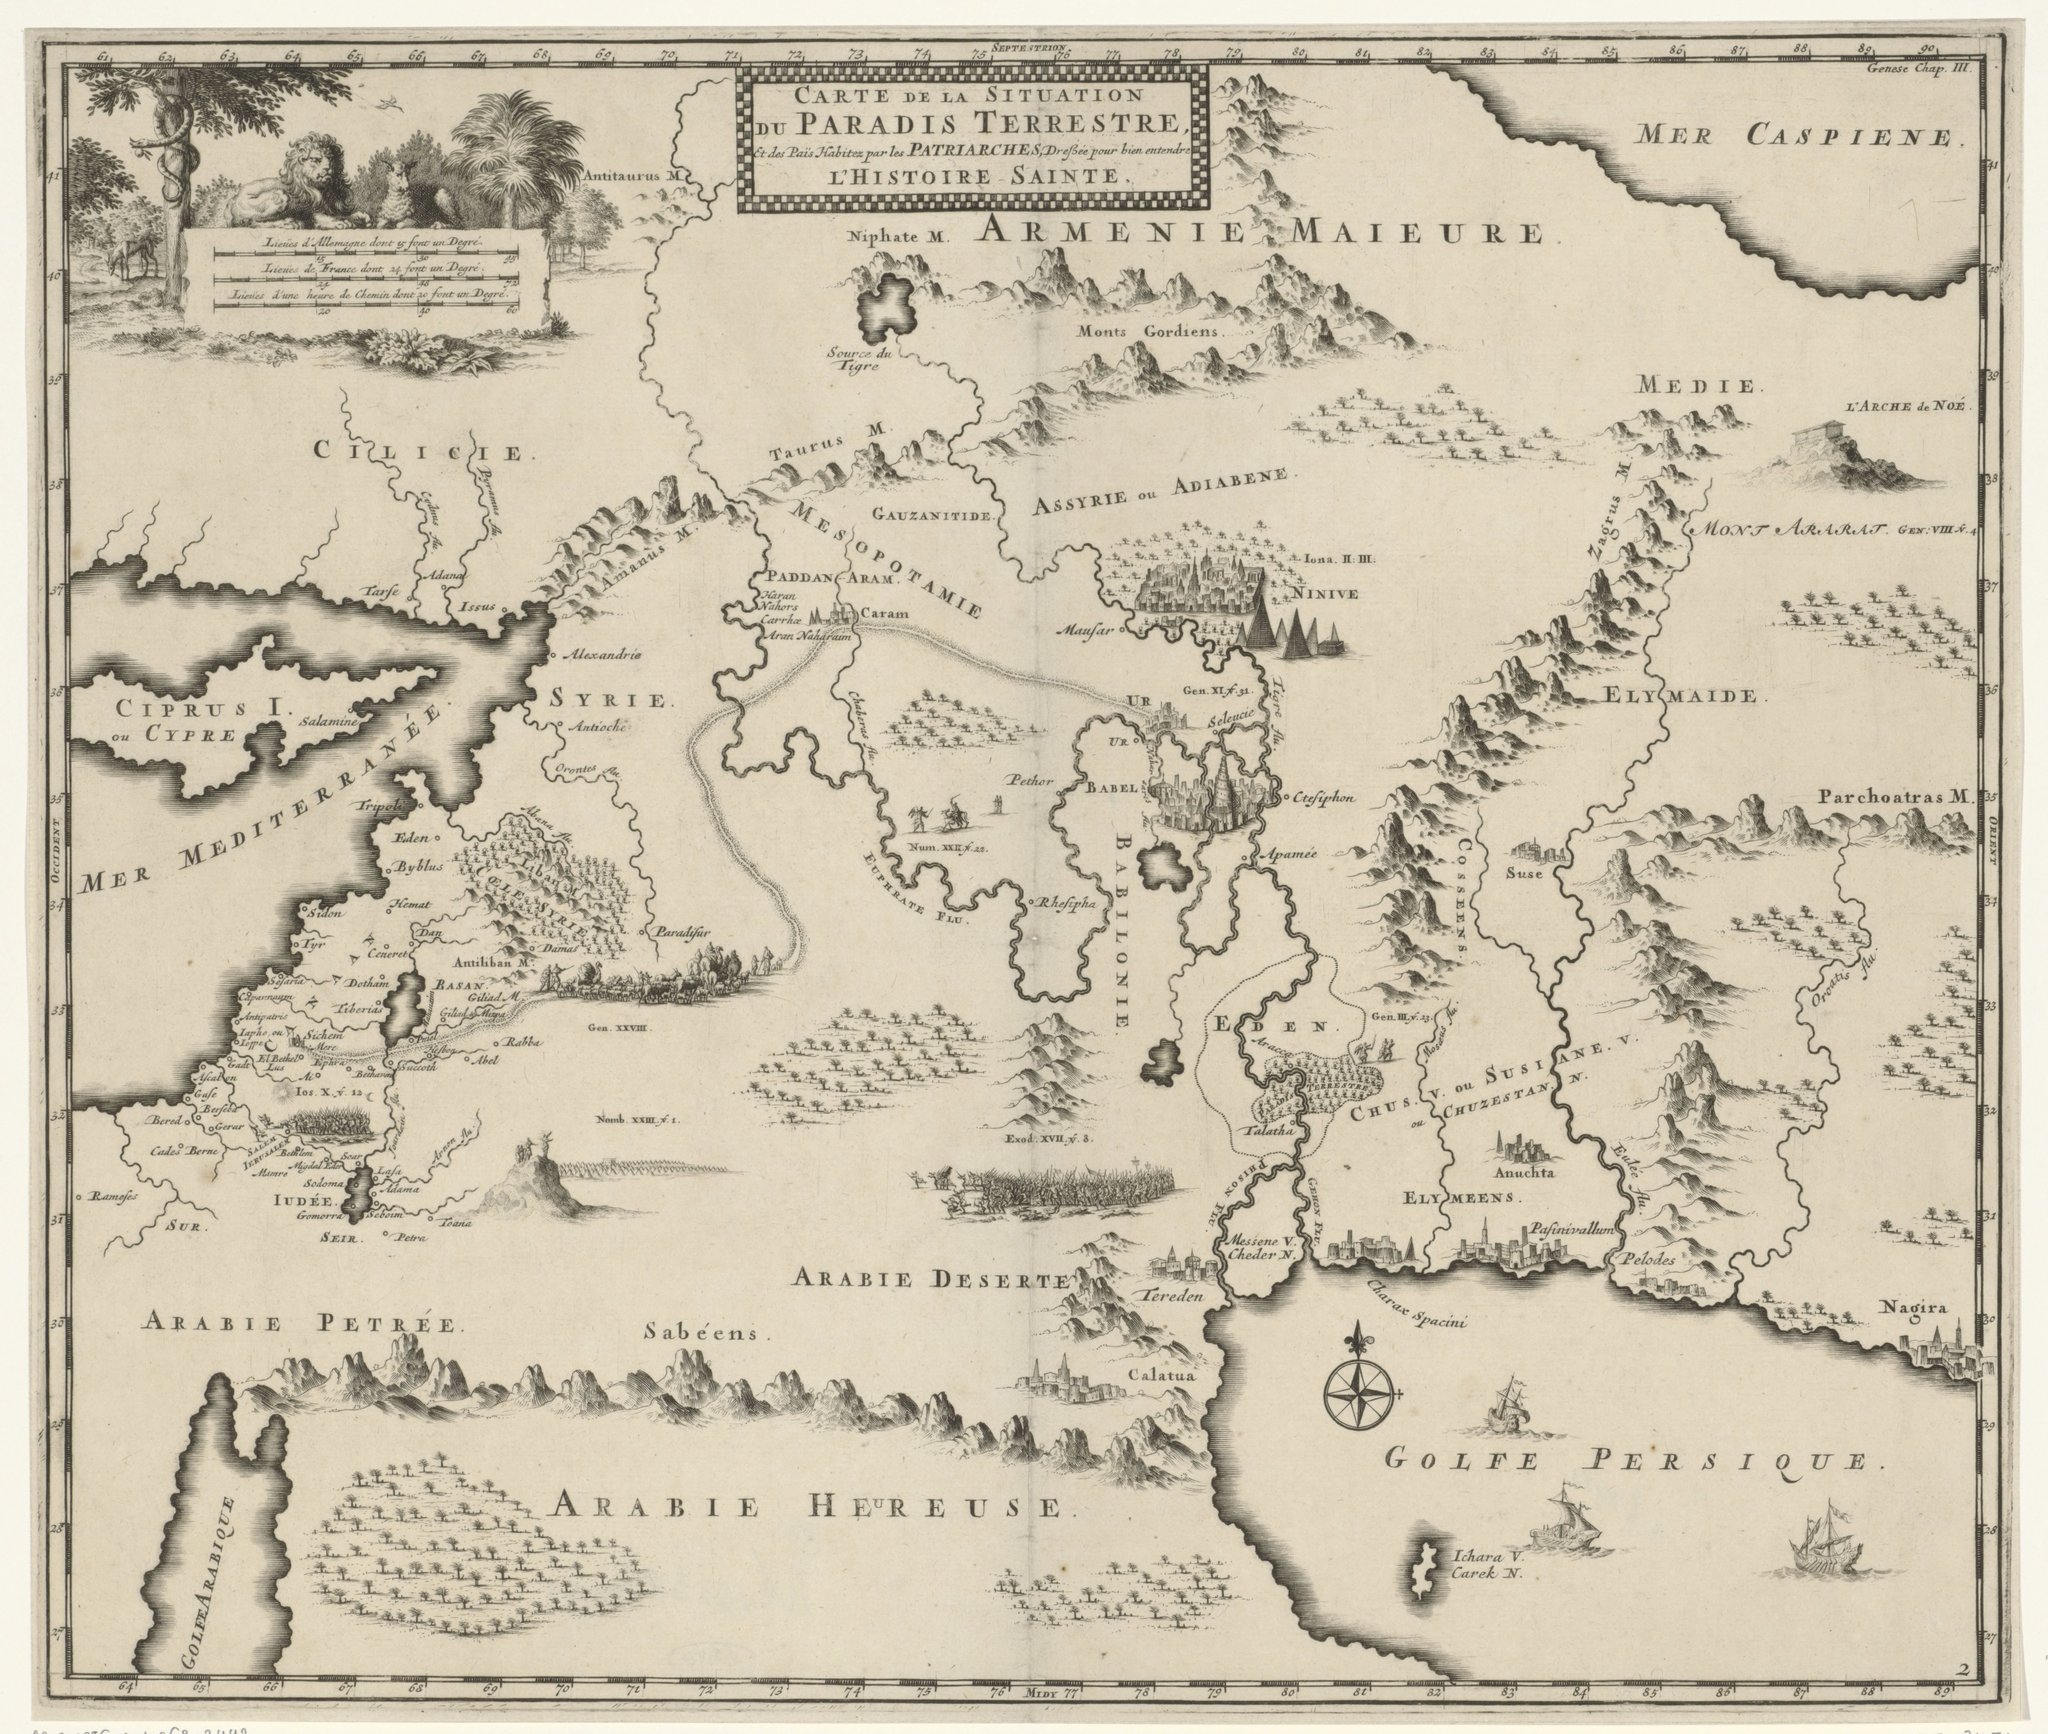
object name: book illustration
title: Carte de la Situation du Paradis Terrestre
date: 1707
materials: paper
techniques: etching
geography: amsterdam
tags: heaven, celestial paradise, new earth, maps of separate countries or regions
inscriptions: collector's mark: Lugt 2228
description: Illustratie in: La sainte Bible, qui contient le Vieux et le Nouveau Testament. Amsterdam: Henri Desbordes, Pieter Mortier en Pierre Brunel, 1707.